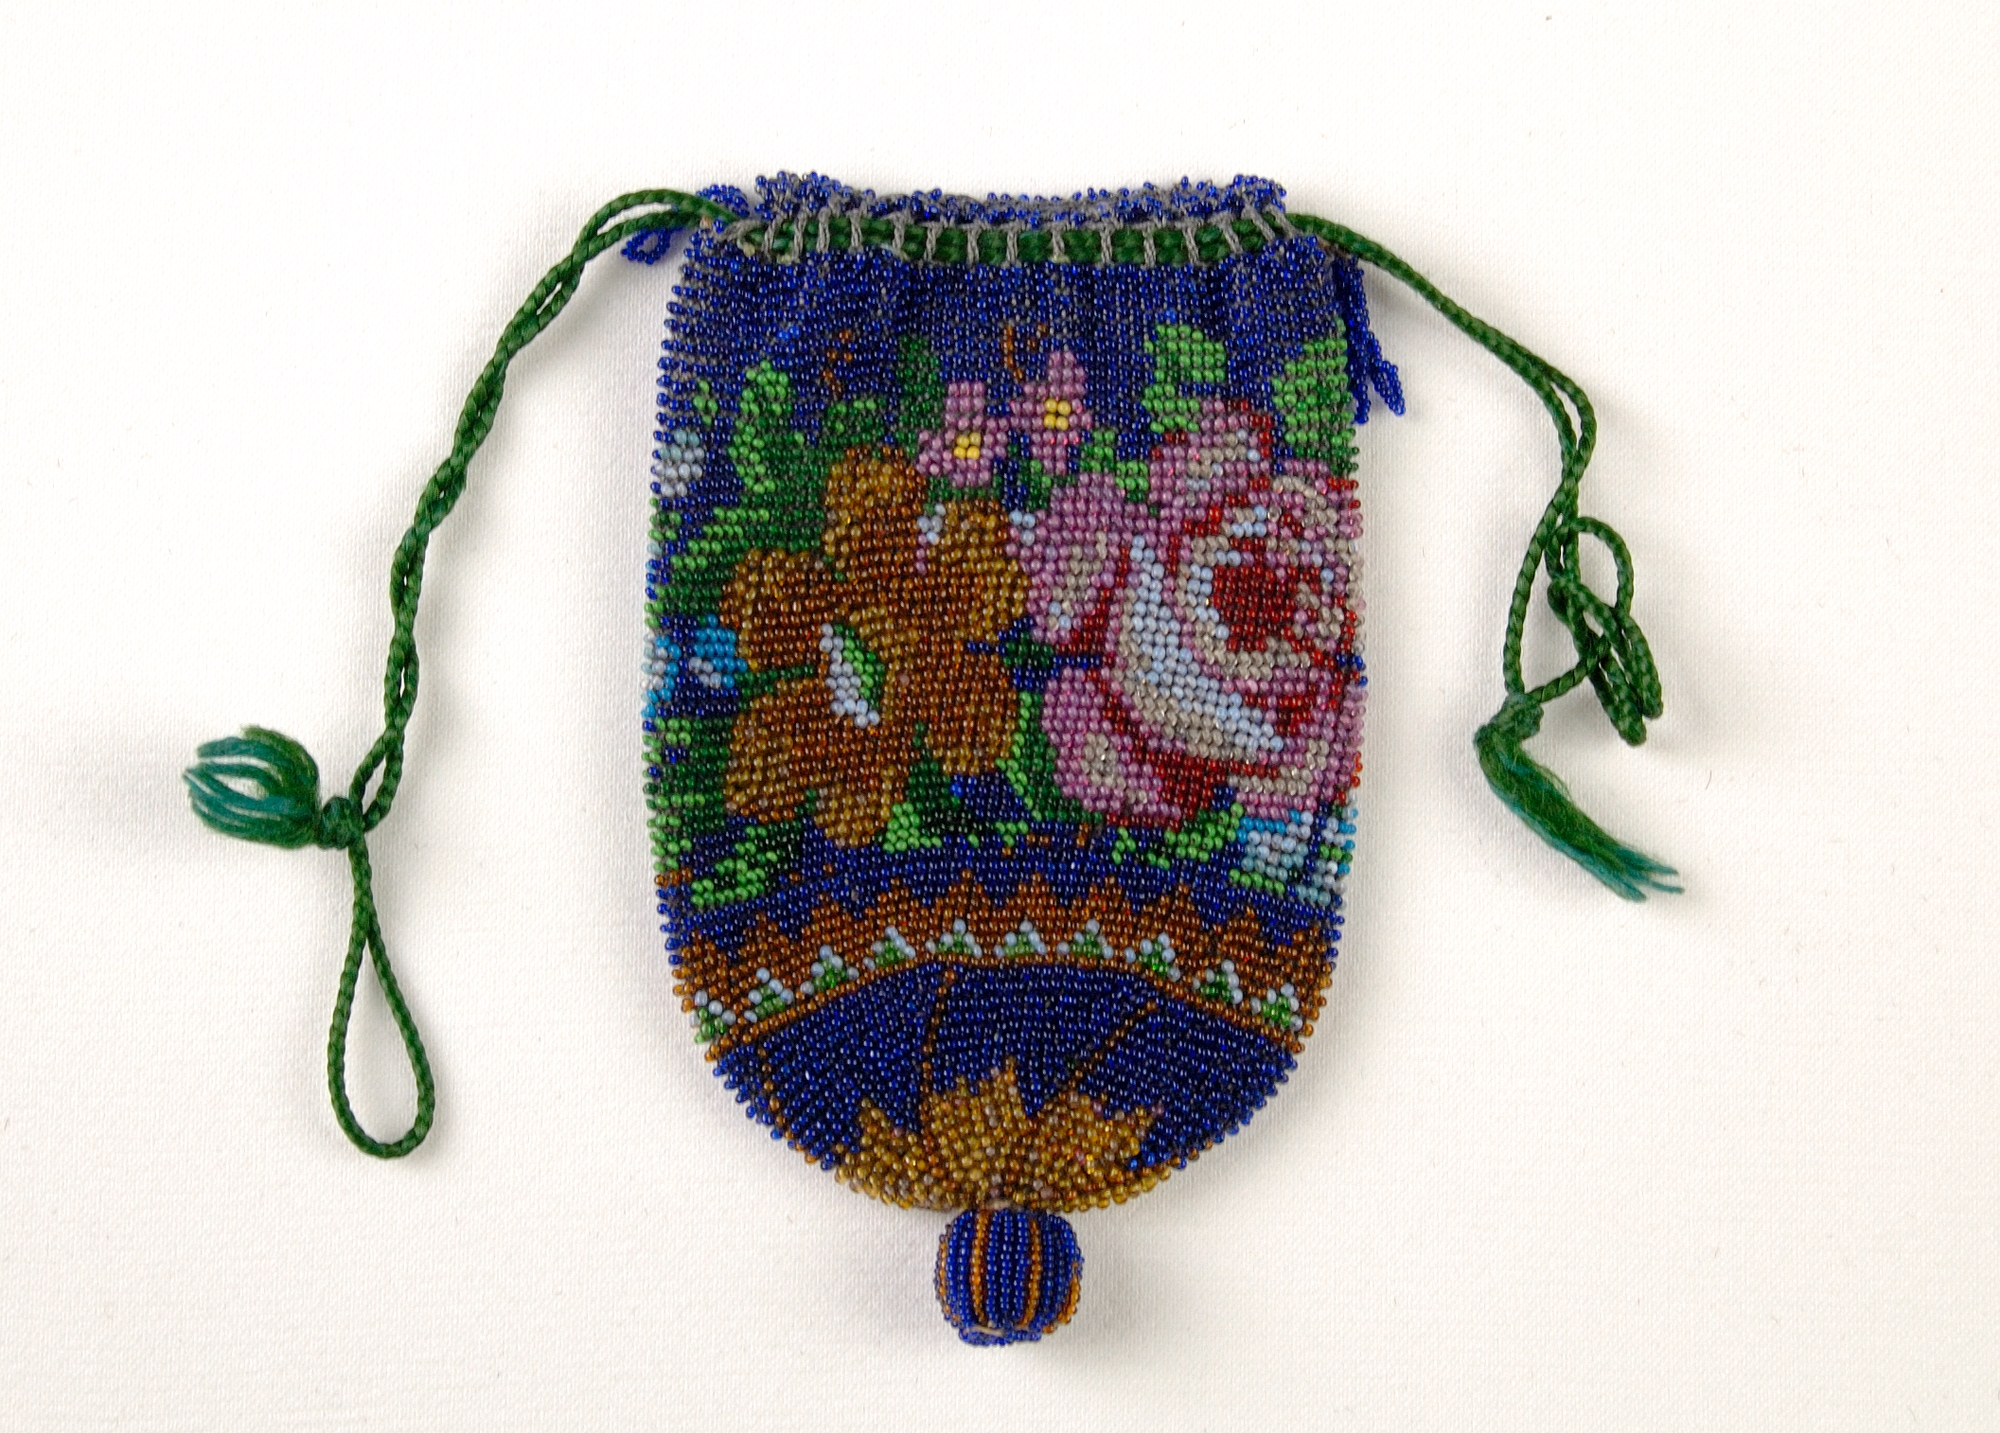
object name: coin purse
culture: american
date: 1830-1860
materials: glass, linen, silk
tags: flowers